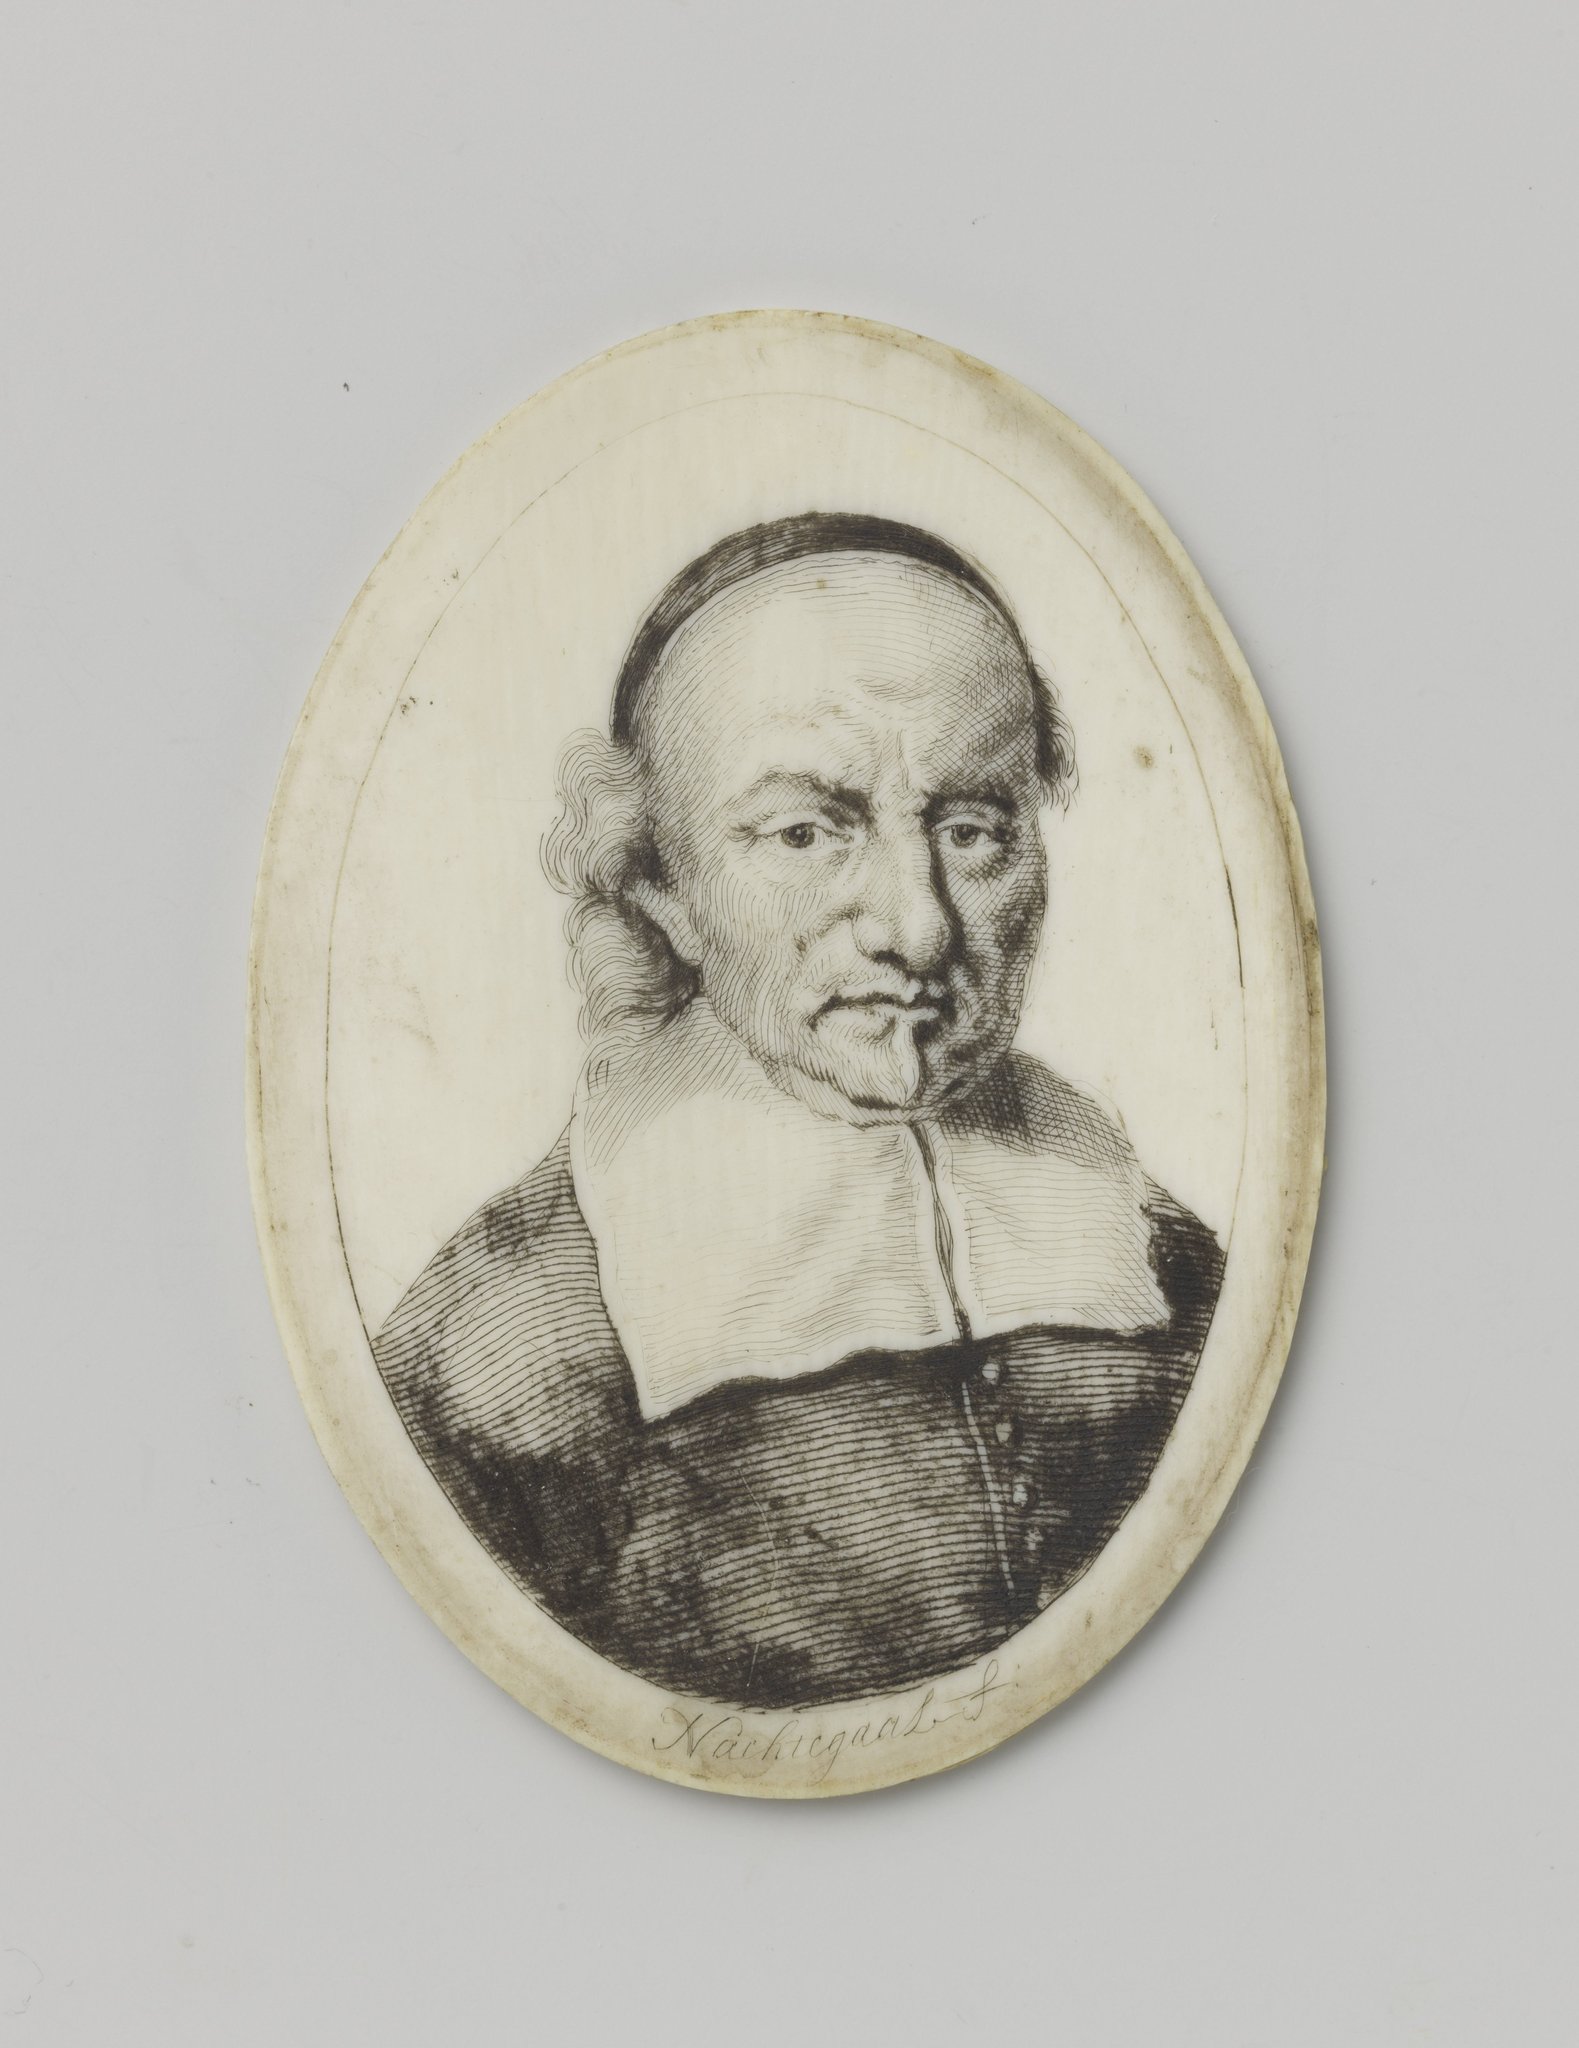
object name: miniature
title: Portret van Joost van den Vondel (1587-1679) op ivoor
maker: clemens nachtegaal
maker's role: print maker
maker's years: 1675-1749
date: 1600-1699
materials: ivory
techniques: pen on ivory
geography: netherlands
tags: amsterdam, joost van den vondel, netherlands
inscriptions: signature: ‘Nachtegaal fecit’, inscription: ‘Joost van den Vondel’, signature: ‘Nachtegaqal f:’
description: Ovale dunne schijf ivoor waarop in pen getekend het borstbeeld van een man. Onder tekening gesigneerd 'Nachtegaal f' en op de achterkant met 'Nachtegaal fecit'. Het portret is dat van een oude man met een kalotje en een vierkante kraag. Dit portret zat oorspronkelijk in een dubbellijst met dat van Const. Huijgens. (NG-KOG-1525-B). Ovalen ivoren portretje, lijst ontbreekt, pen op ivoor. Oudere man met kort haar, slik en kalotje, brede platte kraag, zwart hemd, enigszins naar rechts gewend.